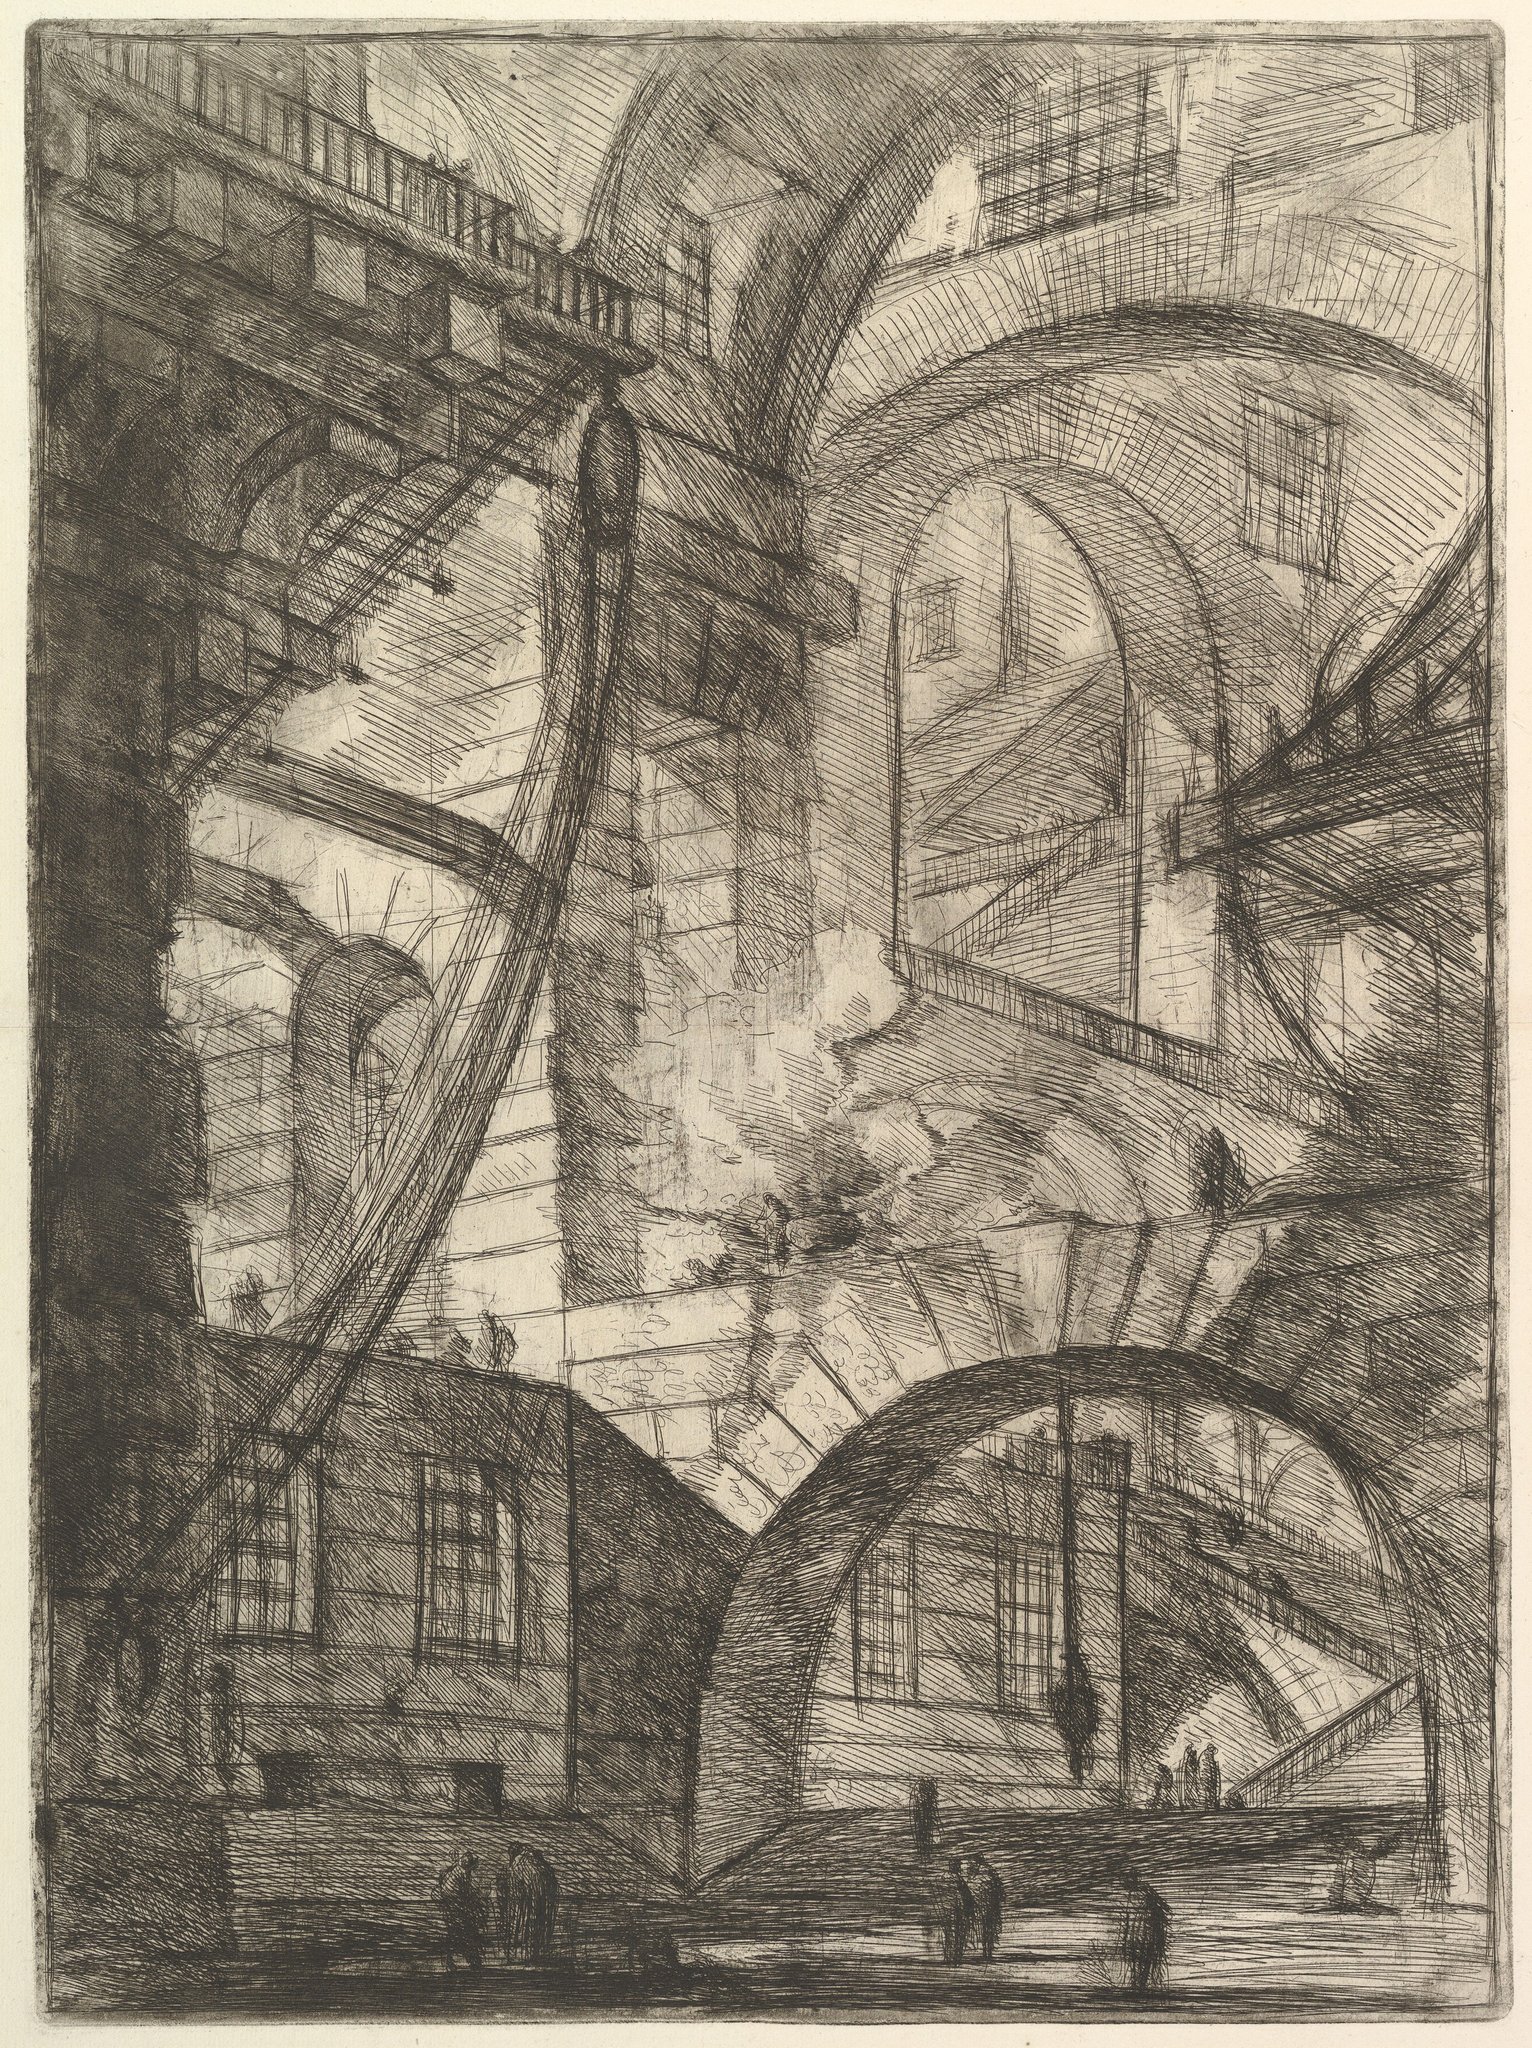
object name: print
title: The Smoking Fire, from "Carceri d'invenzione" (Imaginary Prisons)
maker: giovanni battista piranesi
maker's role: artist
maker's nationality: italian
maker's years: 1720-1778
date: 1749-1750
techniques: burnishing, engraving, etching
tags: human figures,buildings,prisons